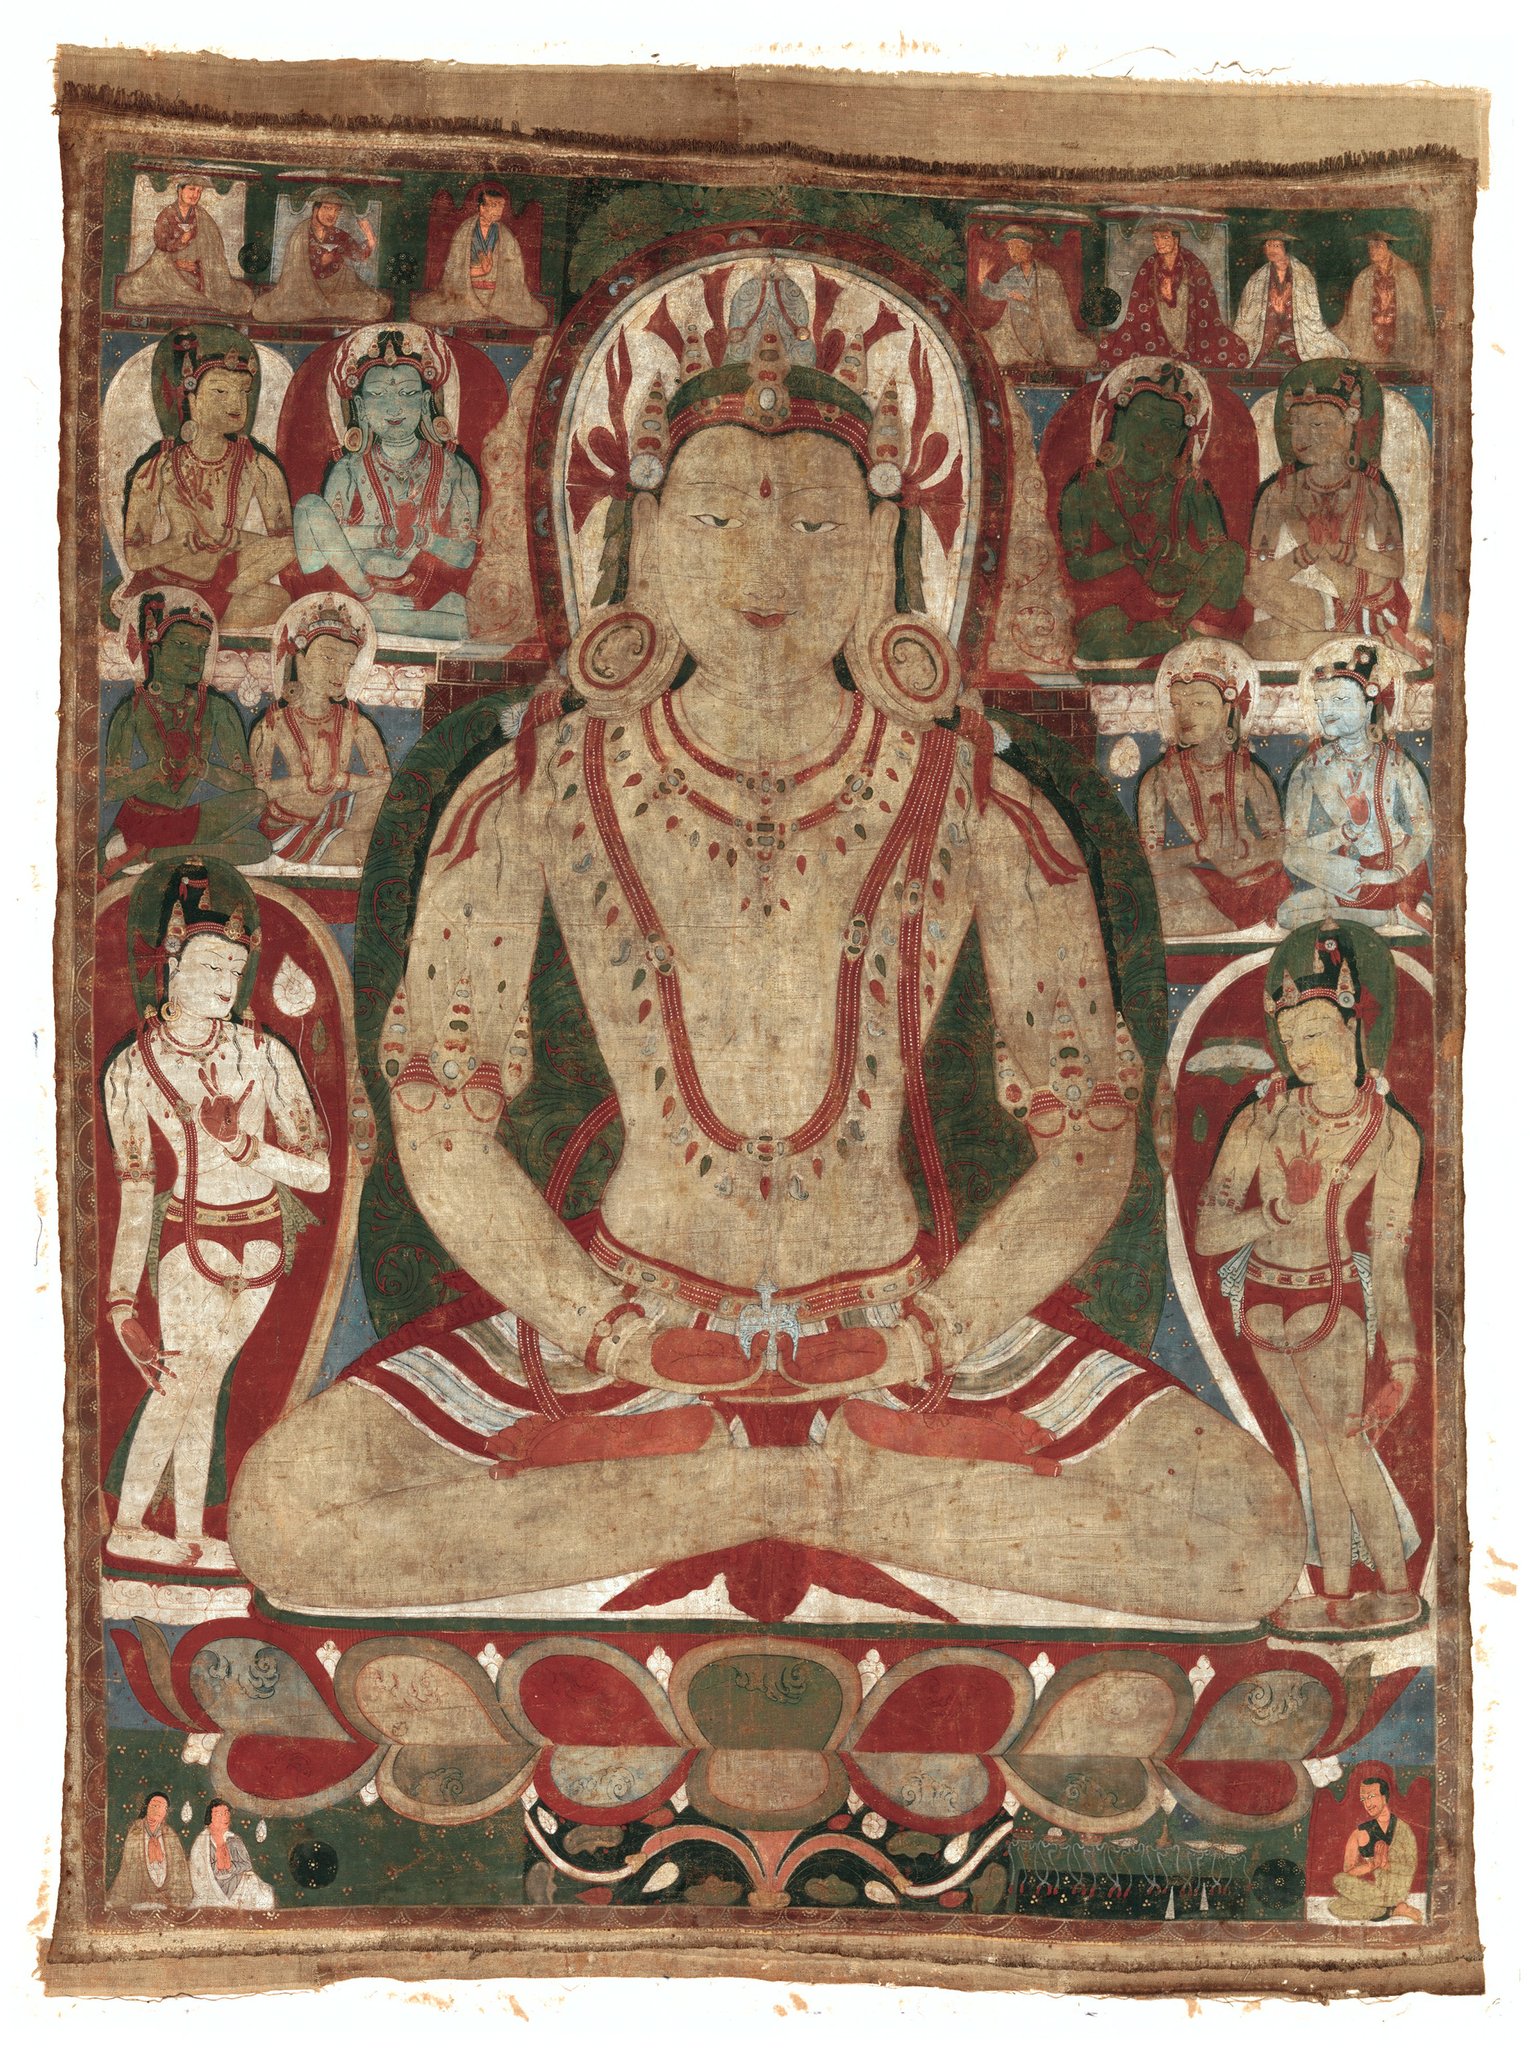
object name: thangka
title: The Bodhisattva Maitreya, Buddha of the Future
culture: tibetan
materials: textile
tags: buddhism,bodhisattvas,buddha